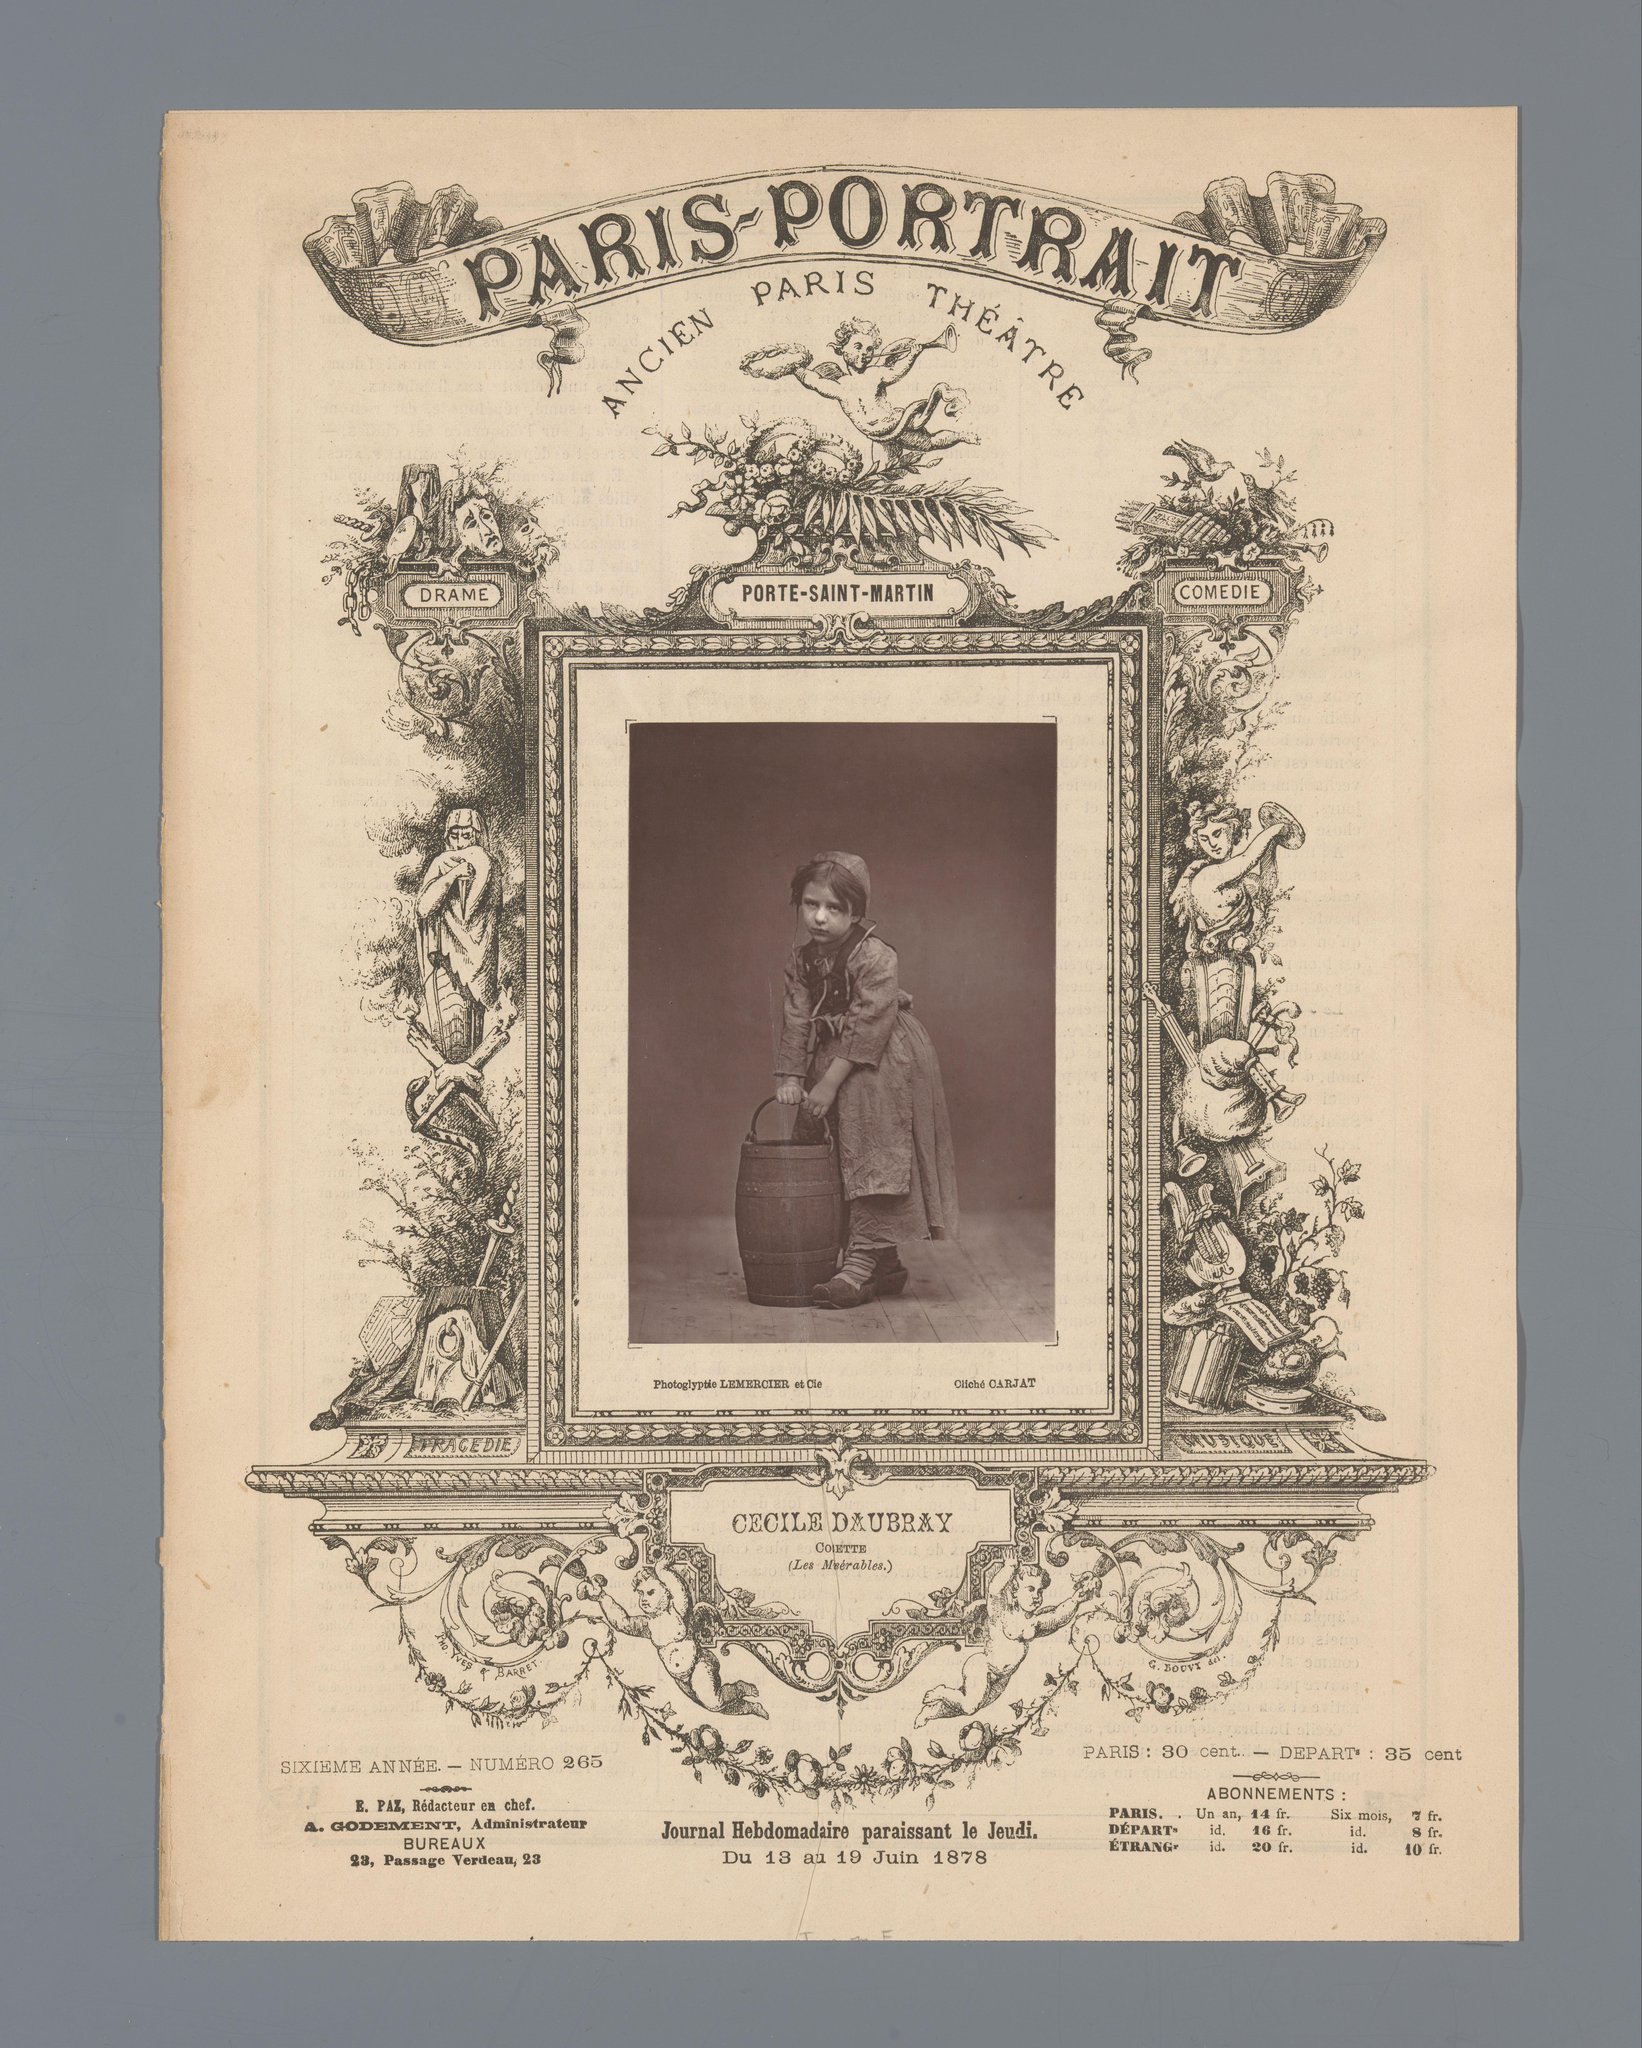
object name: photomechanical print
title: Portret van Cécile Daubray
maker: étienne carjat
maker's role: draughtsman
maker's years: 1828-1906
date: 1873-1880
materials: paper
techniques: woodburytype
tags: historical persons - bb - woman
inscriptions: inscription: ‘Colette (Les Misérables.)’